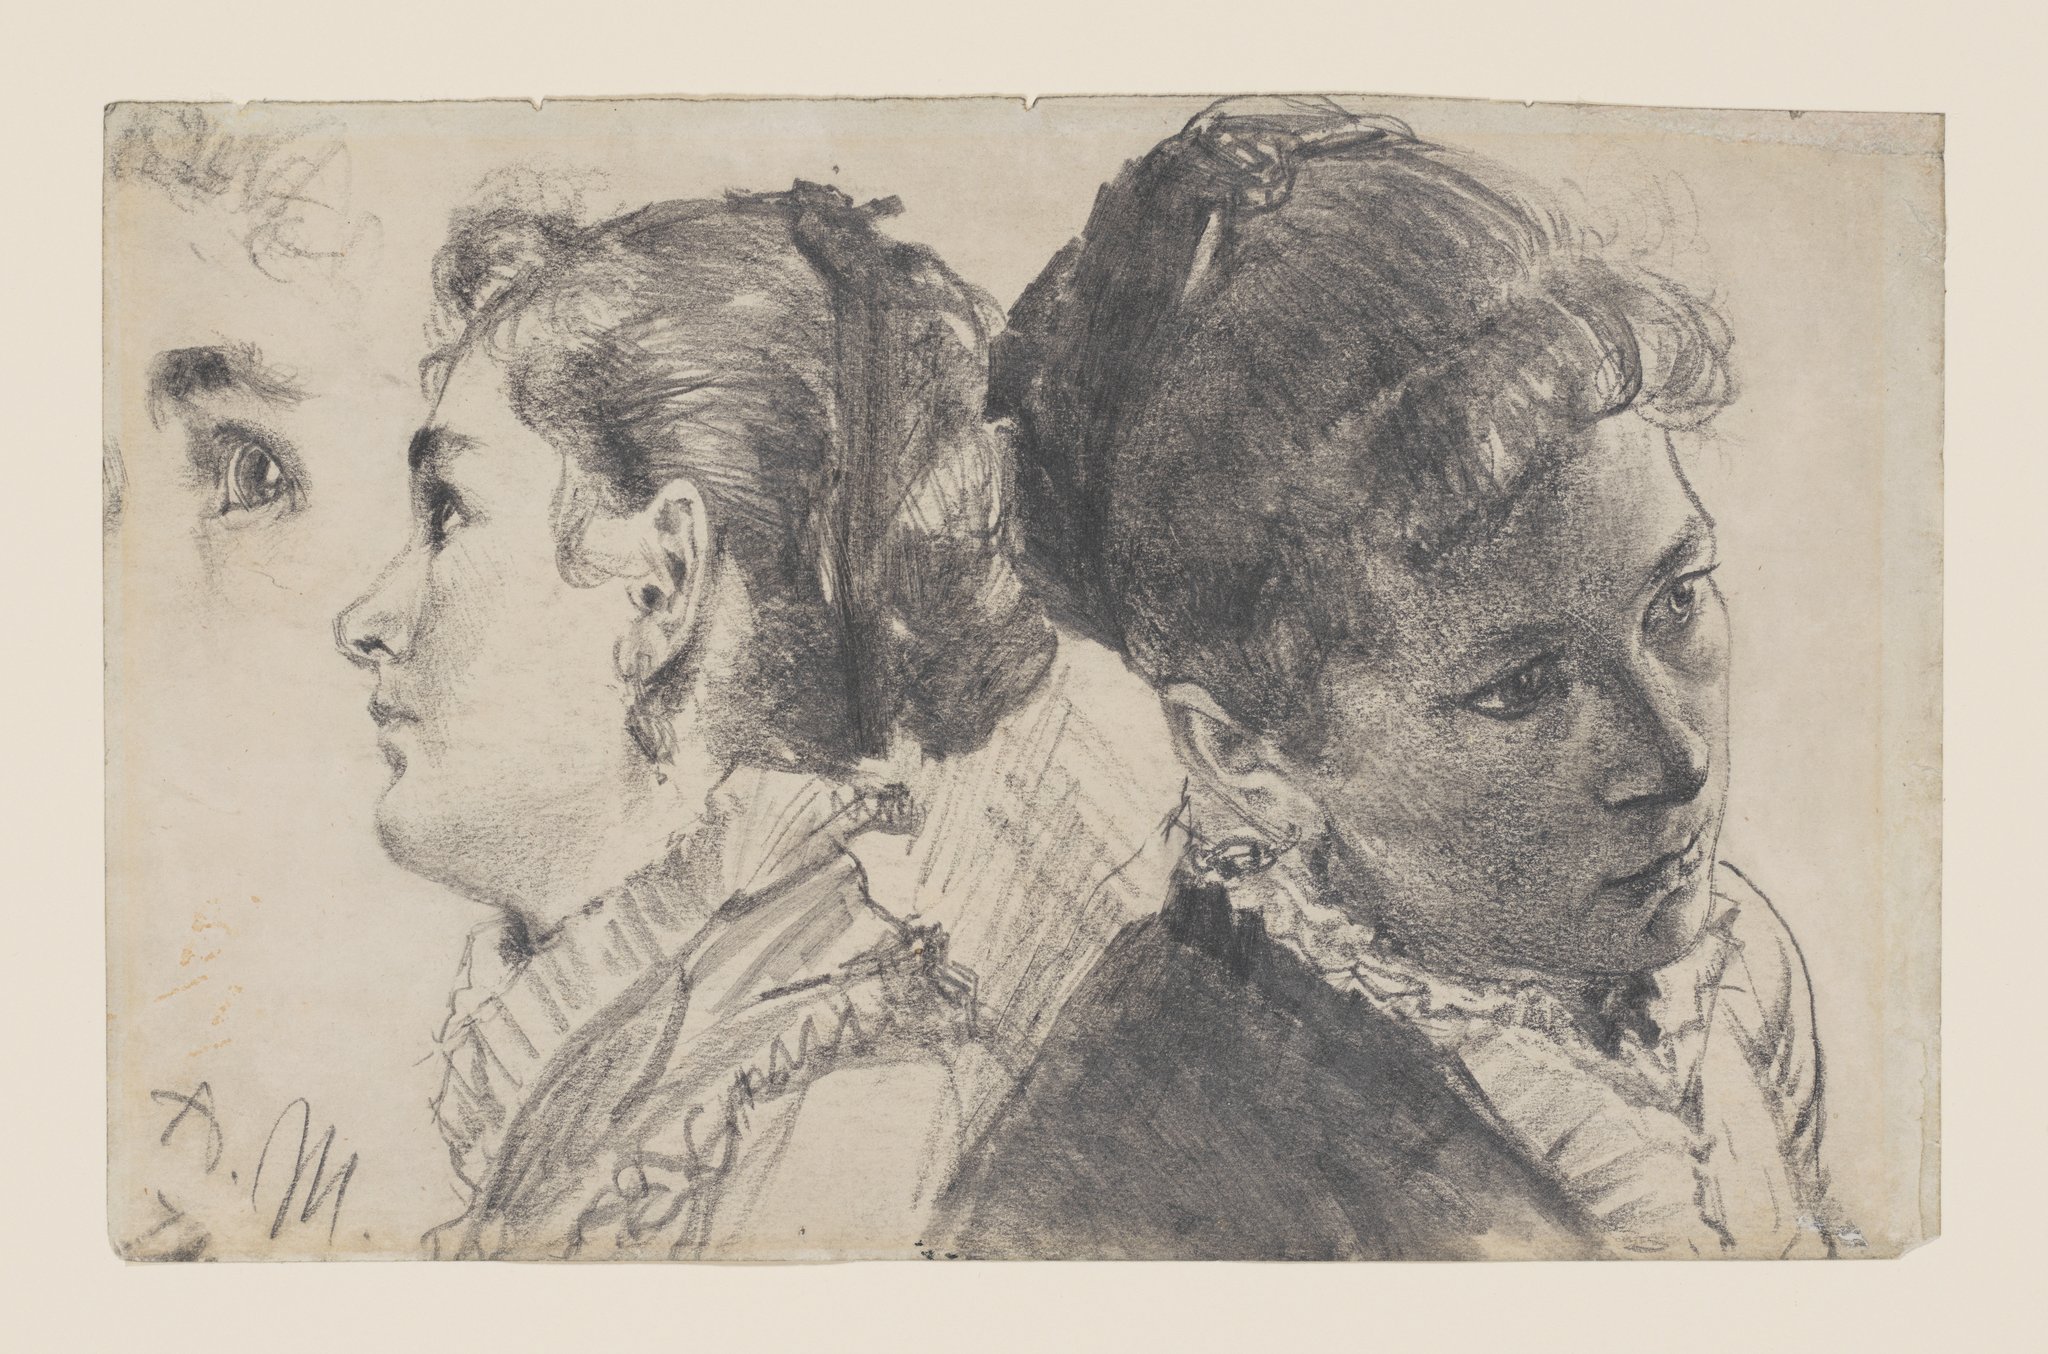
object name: drawing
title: Studies of a Young Woman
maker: adolph menzel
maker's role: artist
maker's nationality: german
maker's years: 1815-1905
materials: graphite, paper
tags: heads,women